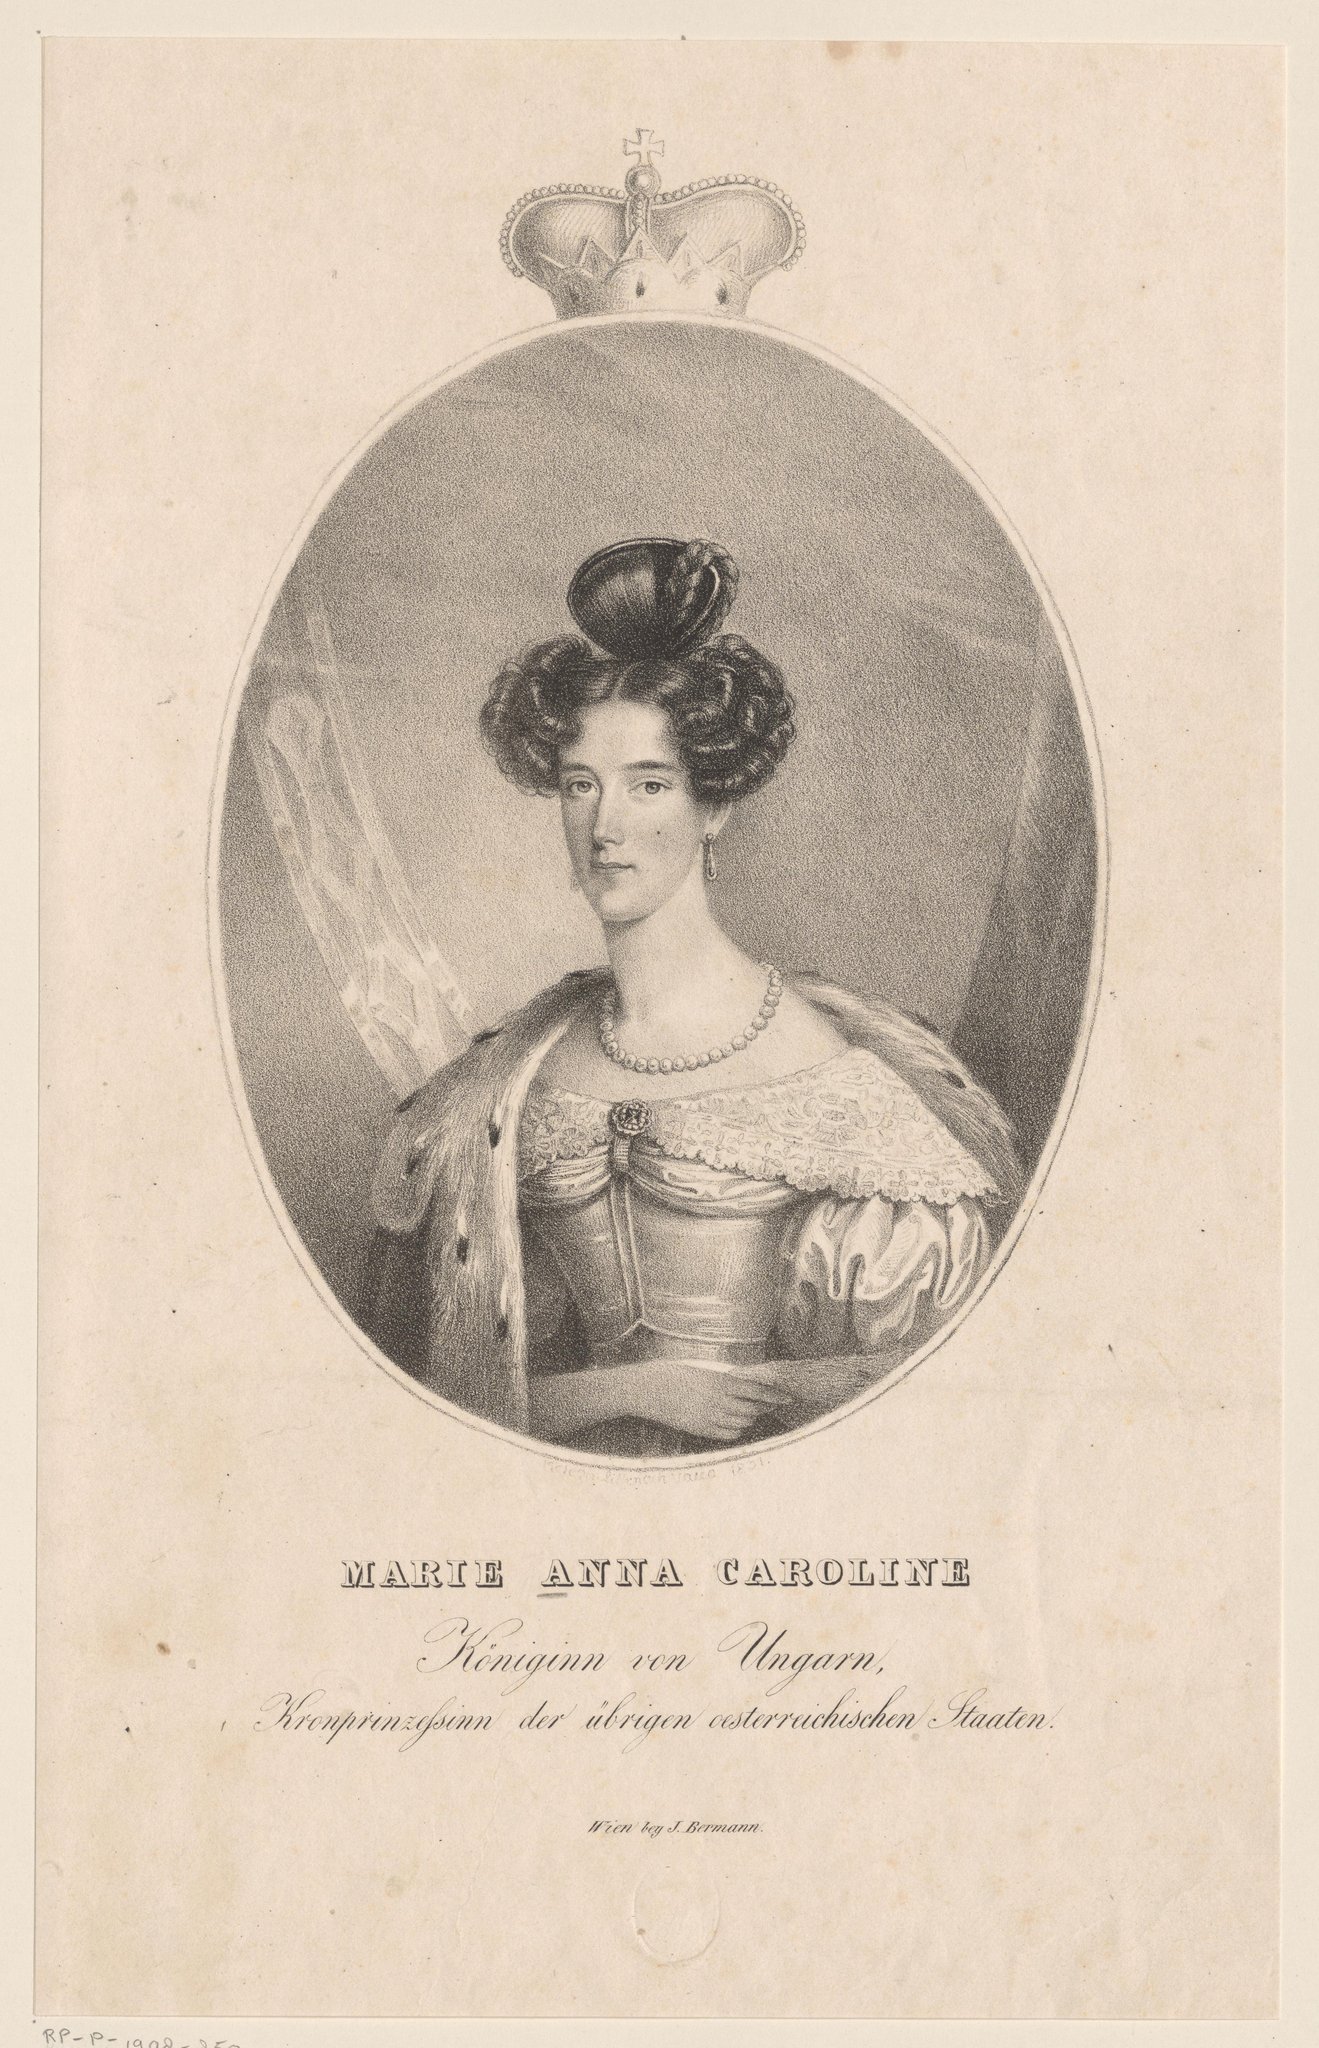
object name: print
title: Portret van Maria Anna van Savoy, keizerin van Oostenrijk en koningin van Hongarije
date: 1831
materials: paper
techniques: lithograph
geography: vienna state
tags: historical persons - bb - woman, insignia and symbols of sovereignty (crown, diadem, sceptre, orb, seal, standard, cloak, pectoral) - bb - female ruler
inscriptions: collector's mark: Lugt 2228